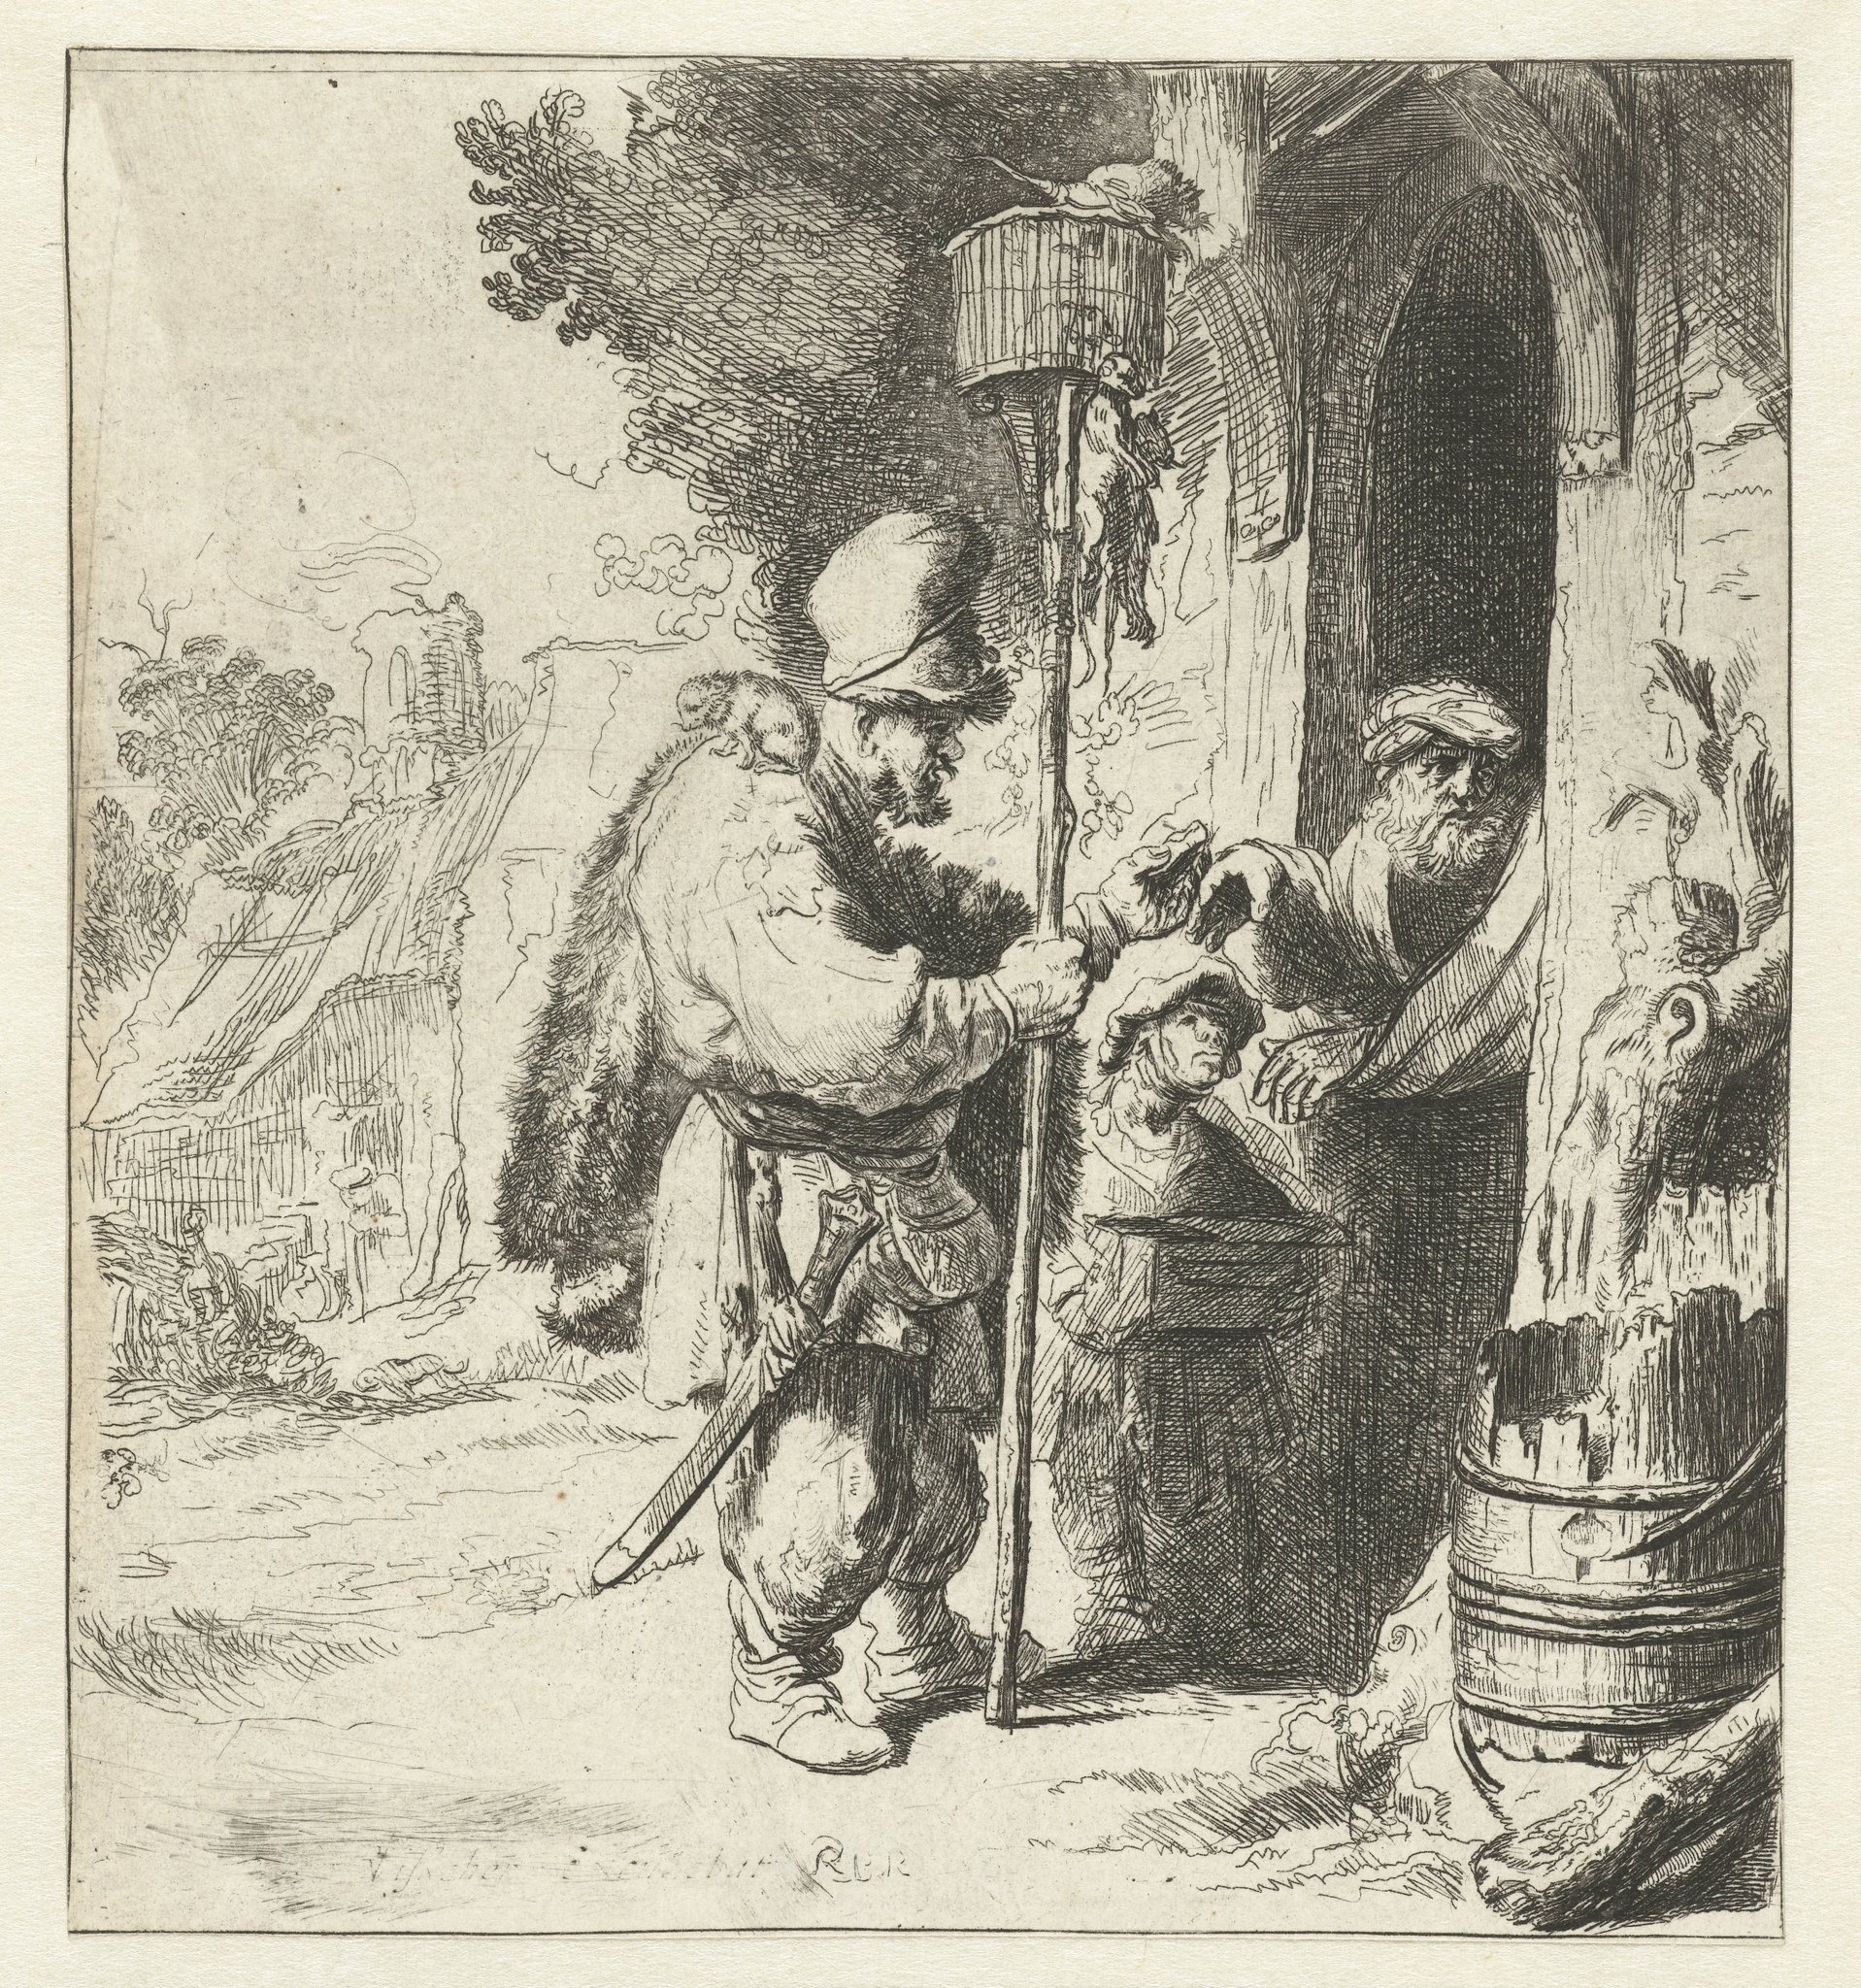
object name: print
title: The rat catcher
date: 1632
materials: paper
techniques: etching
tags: rat exterminator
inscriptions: collector's mark: Lugt 240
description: Spiegelbeeldige kopie naar de gelijknamige prent van Rembrandt.